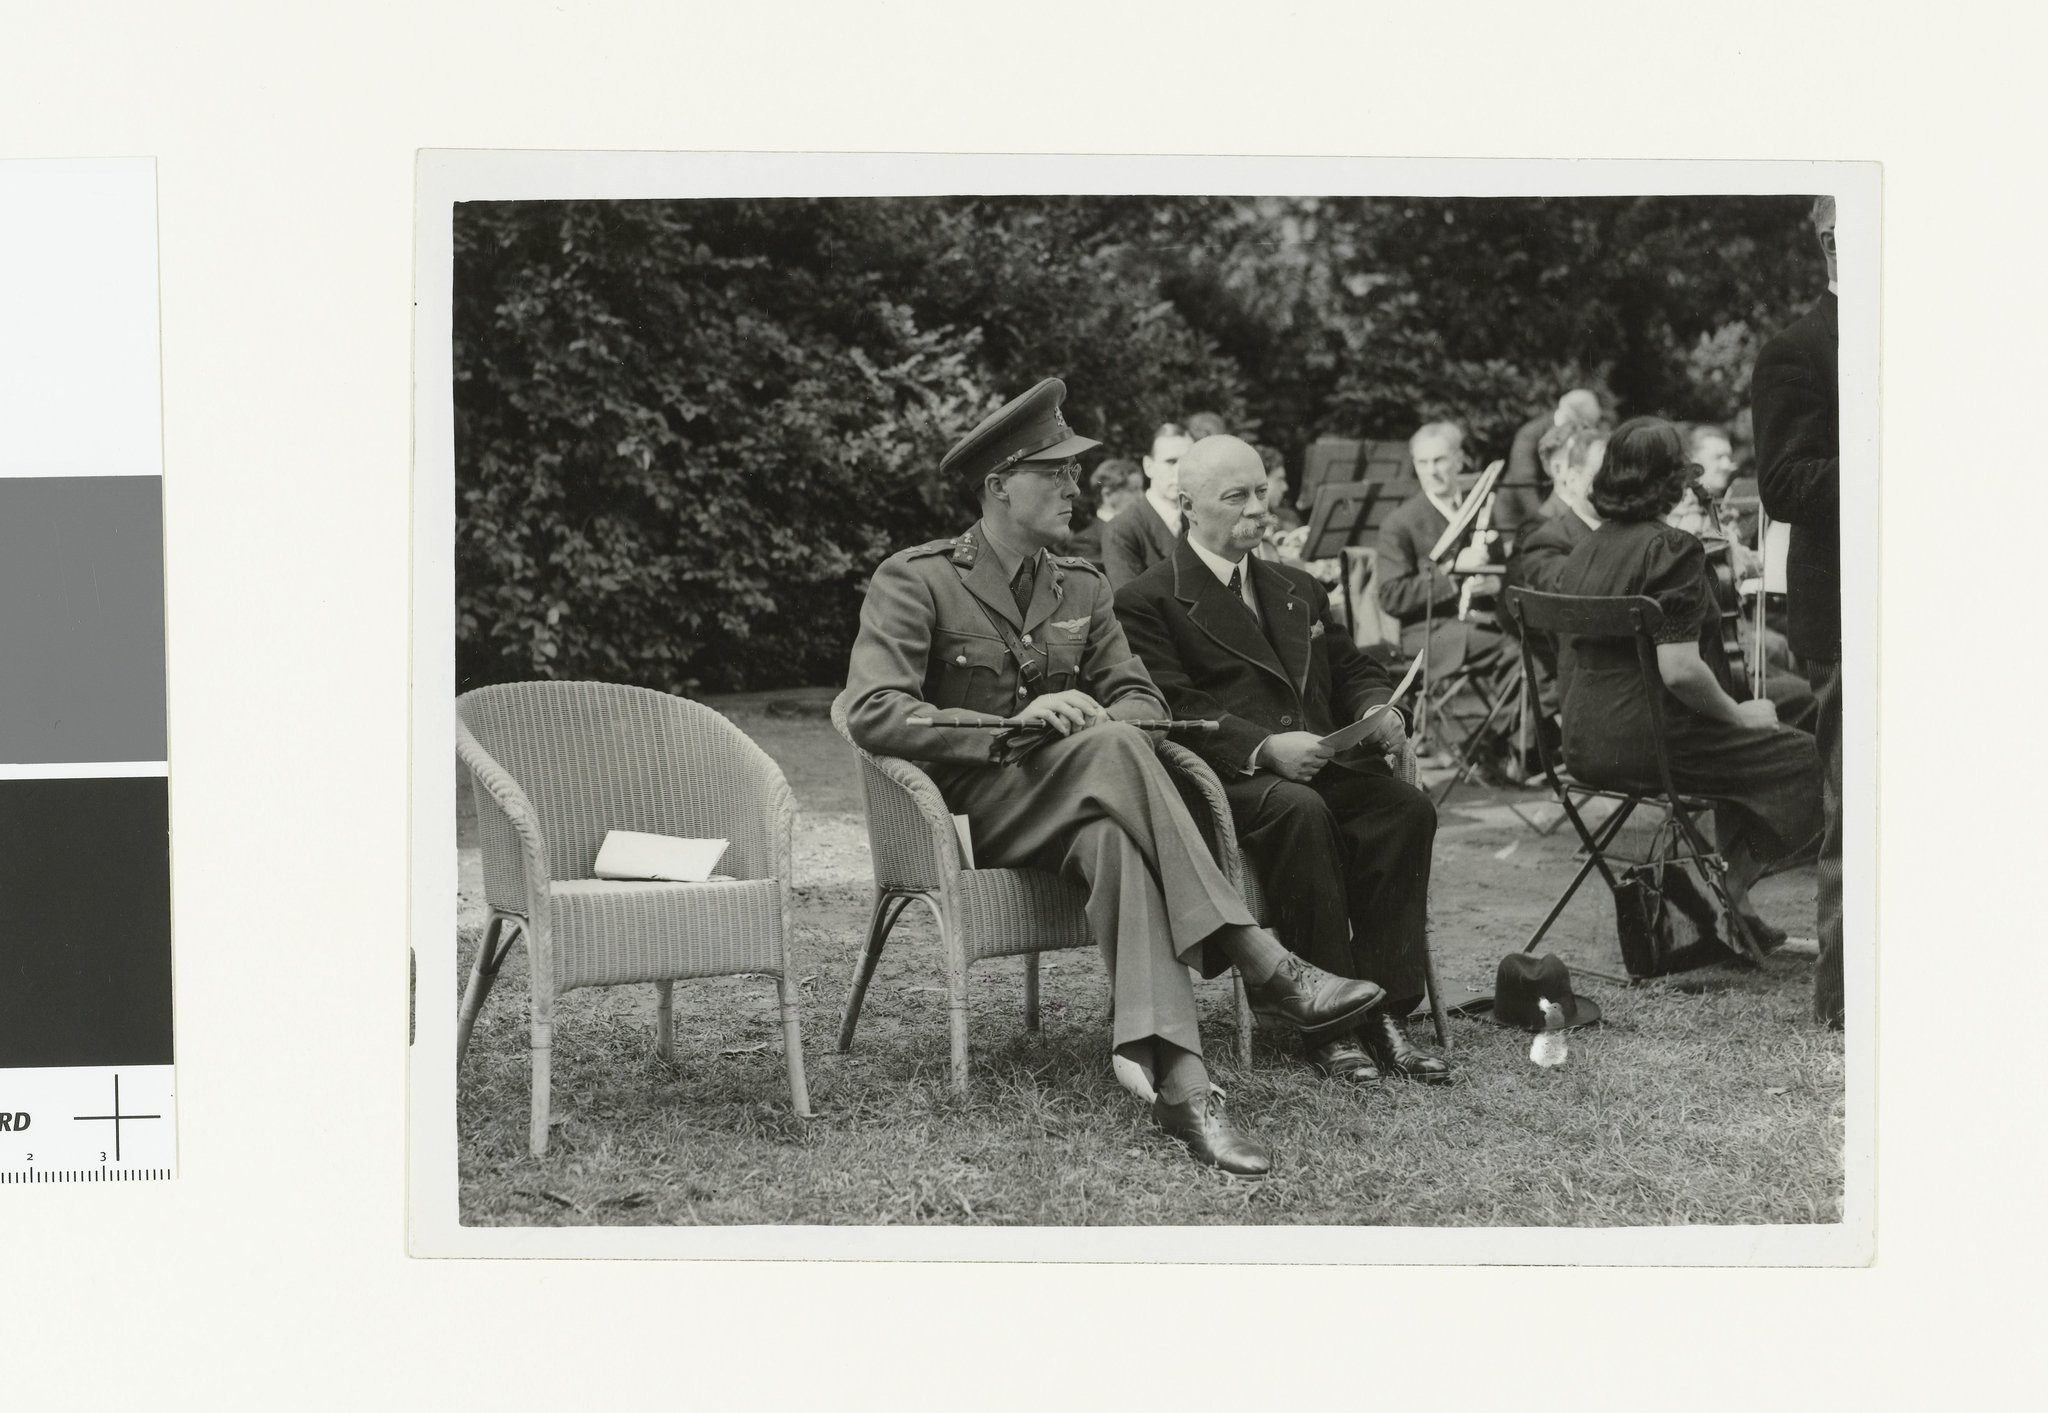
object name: documentary photograph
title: Prins Bernhard en minister-president Gerbrandy vieren de verjaardag van koningin Wilhelmina in Regents Park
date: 1941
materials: photographic support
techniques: photography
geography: london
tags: the hague, wilhelmina of the netherlands, utrecht, bernhard (prins der nederlanden), pieter sjoerds gerbrandy, prime minister, london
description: In Regents Park zitten Prins Bernhard, in militair uniform, en minister-president Gebrandy te luisteren naar een concert ter ere van de verjaardag van koningin Wilhelmina. Koningin Wilhelmina bezocht overigens zelf deze festiviteiten rondom haar verjaardag nooit.